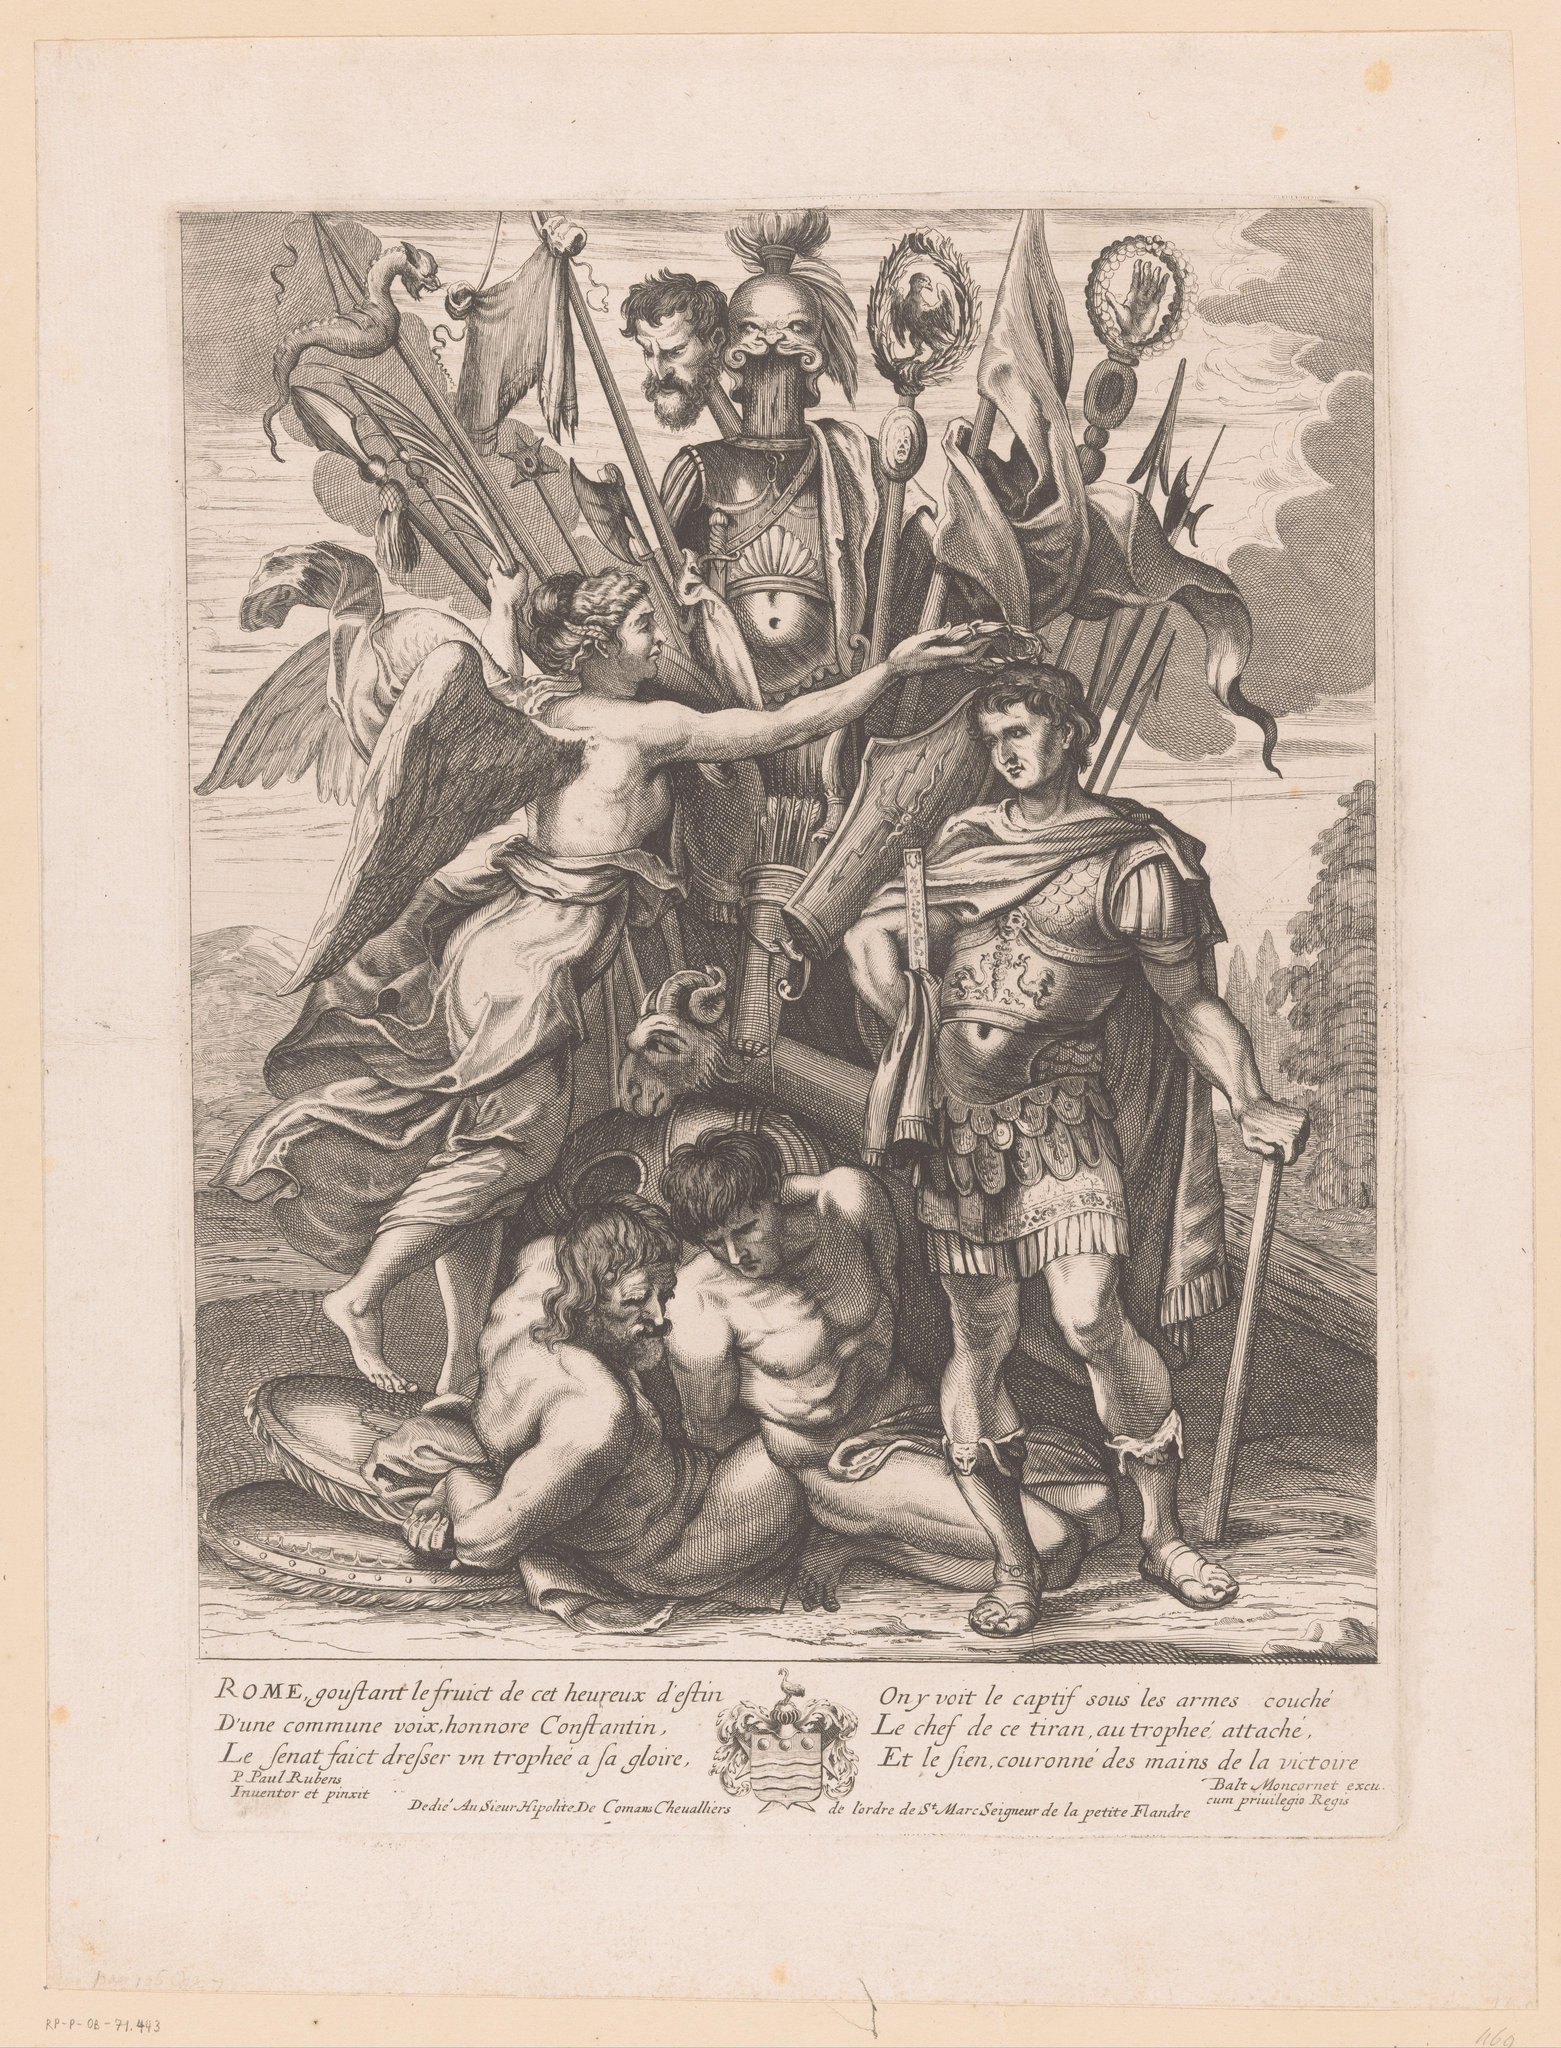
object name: print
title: Trofee van Constantijn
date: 1650-1668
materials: paper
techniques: engraving, etching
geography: france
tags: triumphs (allegorical and symbolic), violent death by beheading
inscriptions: collector's mark: Lugt 240